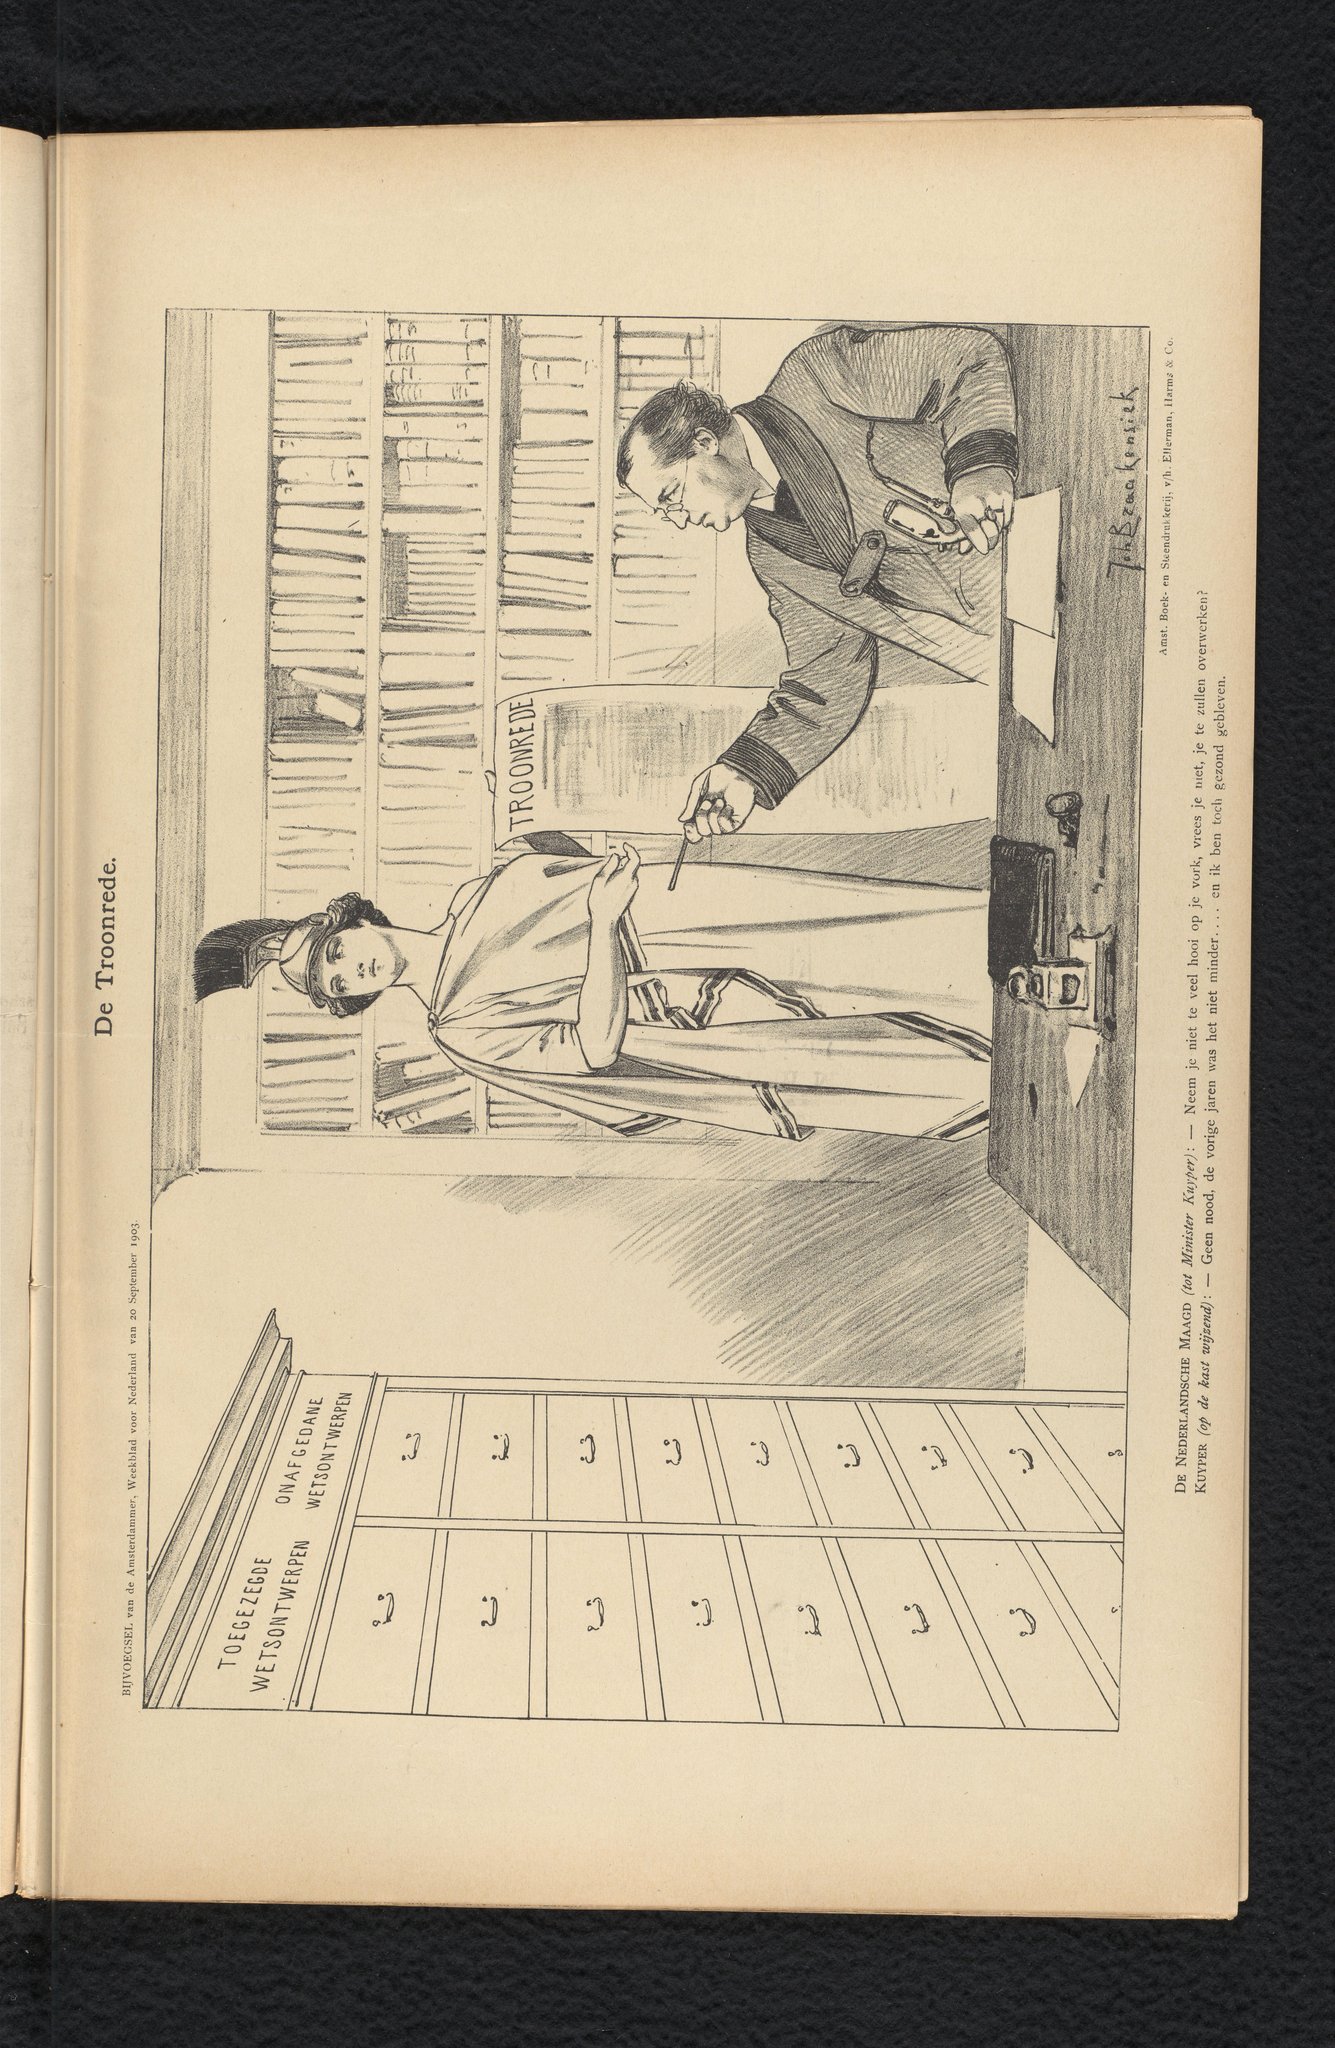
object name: cartoon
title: De Troonrede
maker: johan braakensiek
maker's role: draughtsman, print maker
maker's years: 1858-1940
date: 1903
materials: paper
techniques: lithograph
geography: netherlands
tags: the hague, abraham kuyper, prime minister, personifications of countries, nations, states, districts, etc., political caricatures and satires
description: De Nederlandse Maagd waarschuwt minister Kuyper in de troonrede niet te veel hooi op de vork te nemen. Kuyper wijst op een kast met toegezegde en onafgedane wetsontwerpen van de voorgaande jaren.